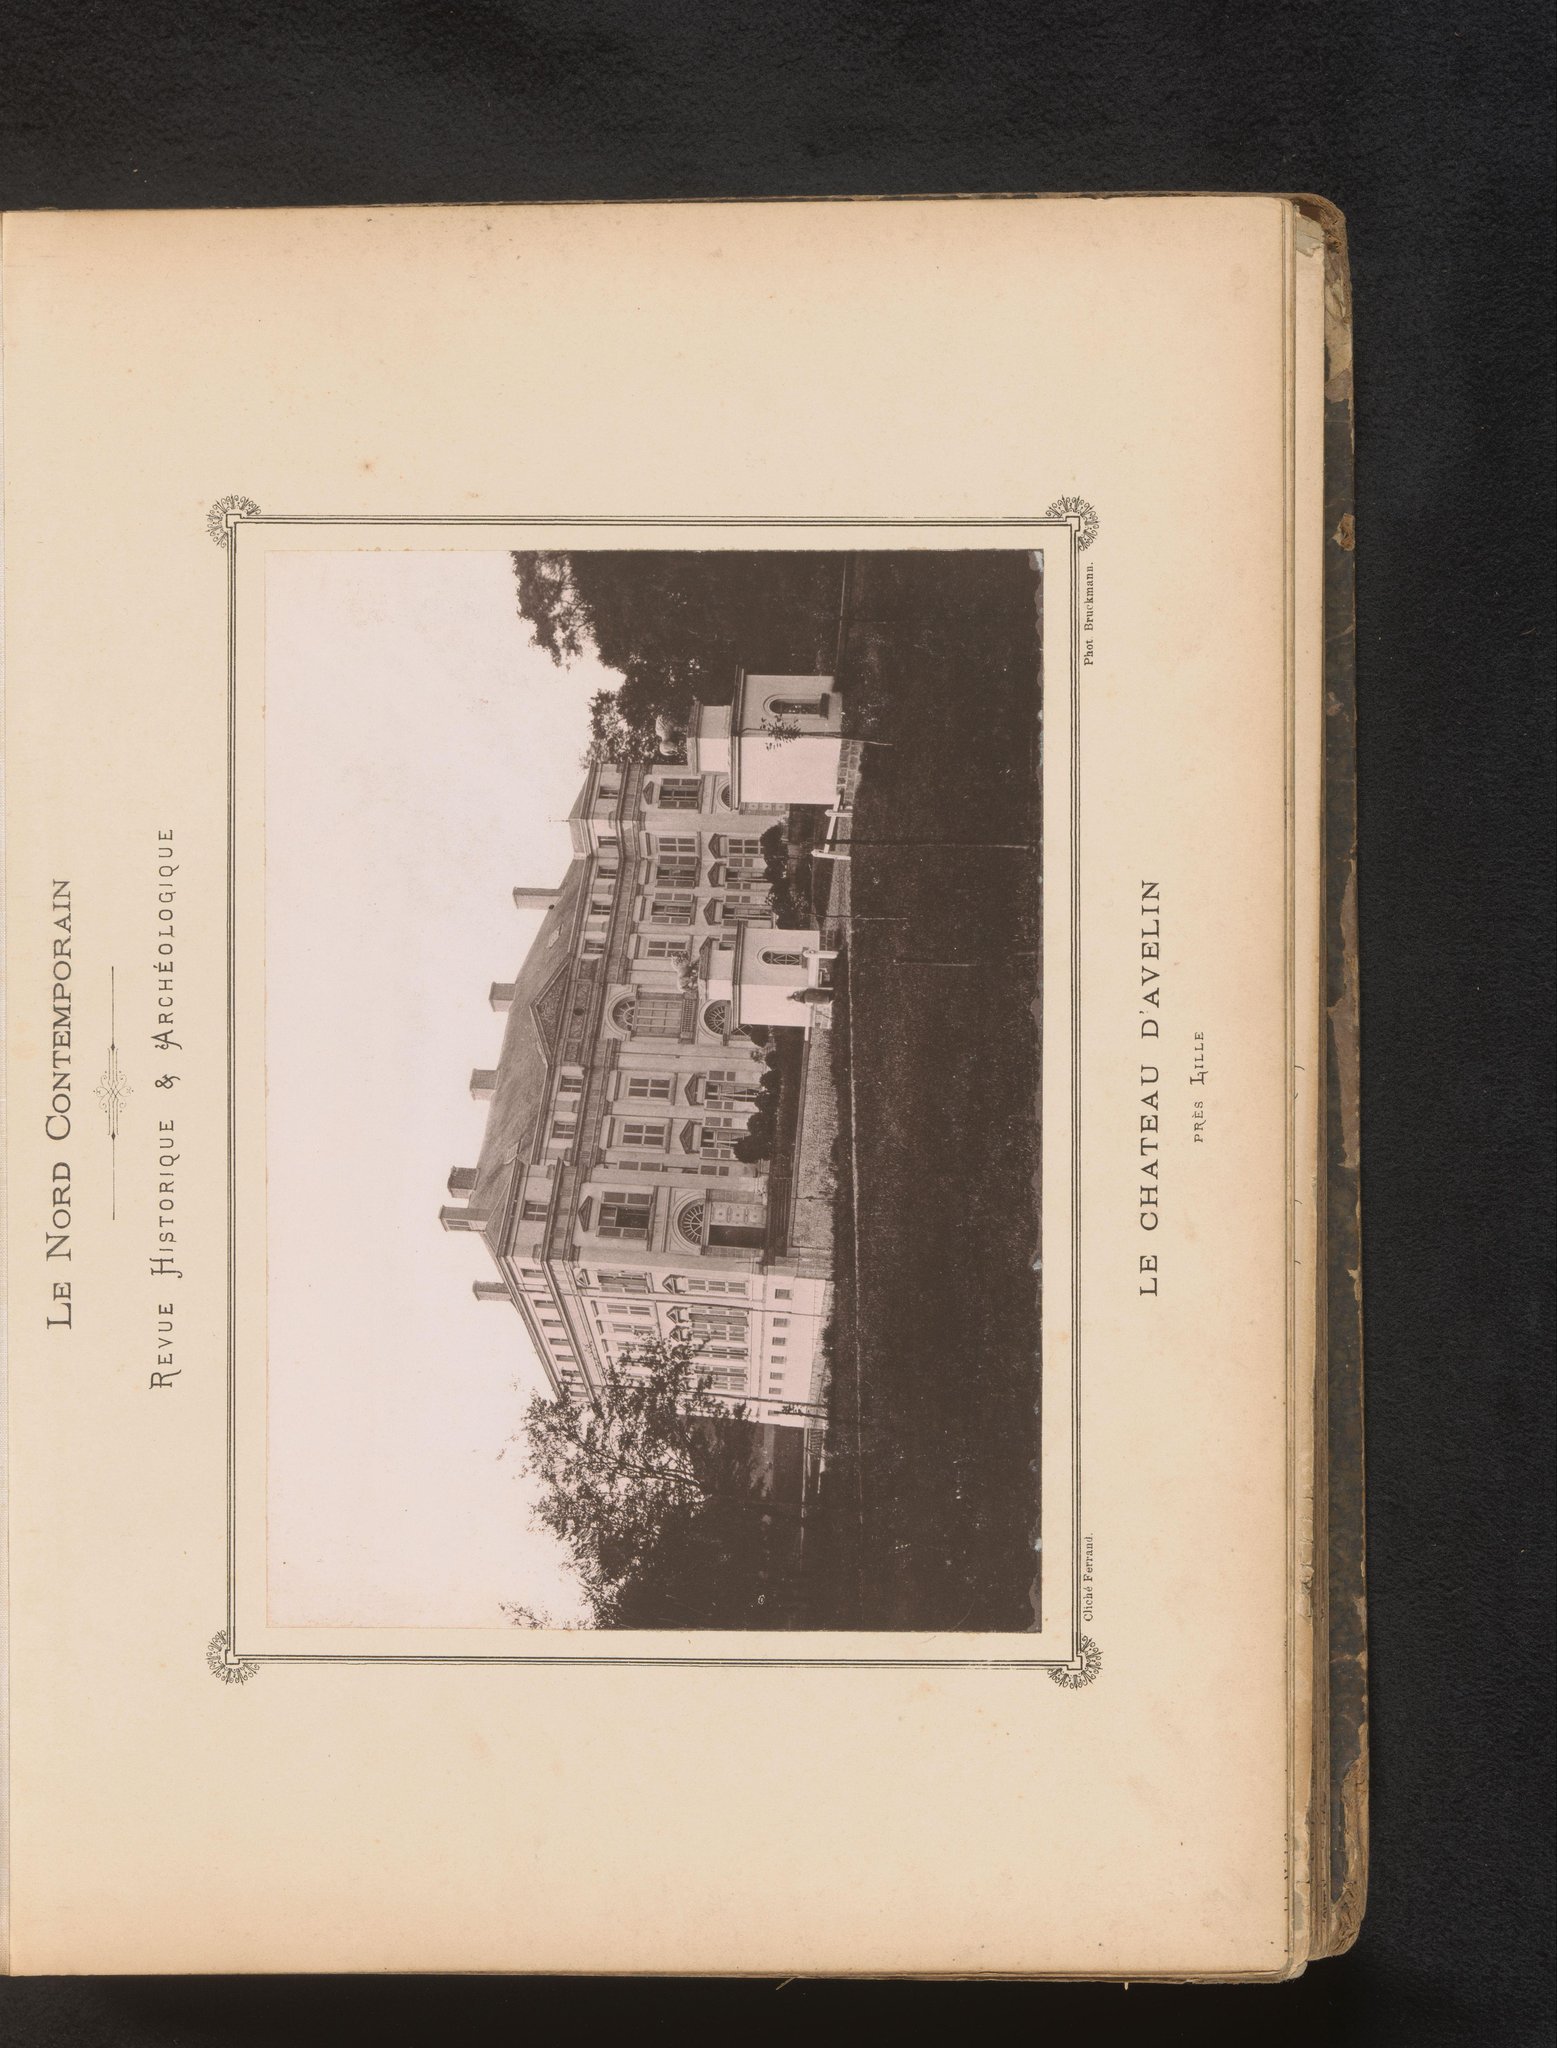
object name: page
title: Le Chateau d'Avelin, près Lille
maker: ferrand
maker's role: clichémaker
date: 1877-1882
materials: paper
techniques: photograph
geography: avelin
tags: castle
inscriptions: inscription: ‘Le Nord Contemporain/ Revue Historique & Archéologique’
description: Prent op derde ongenummerde pagina na pagina 320.